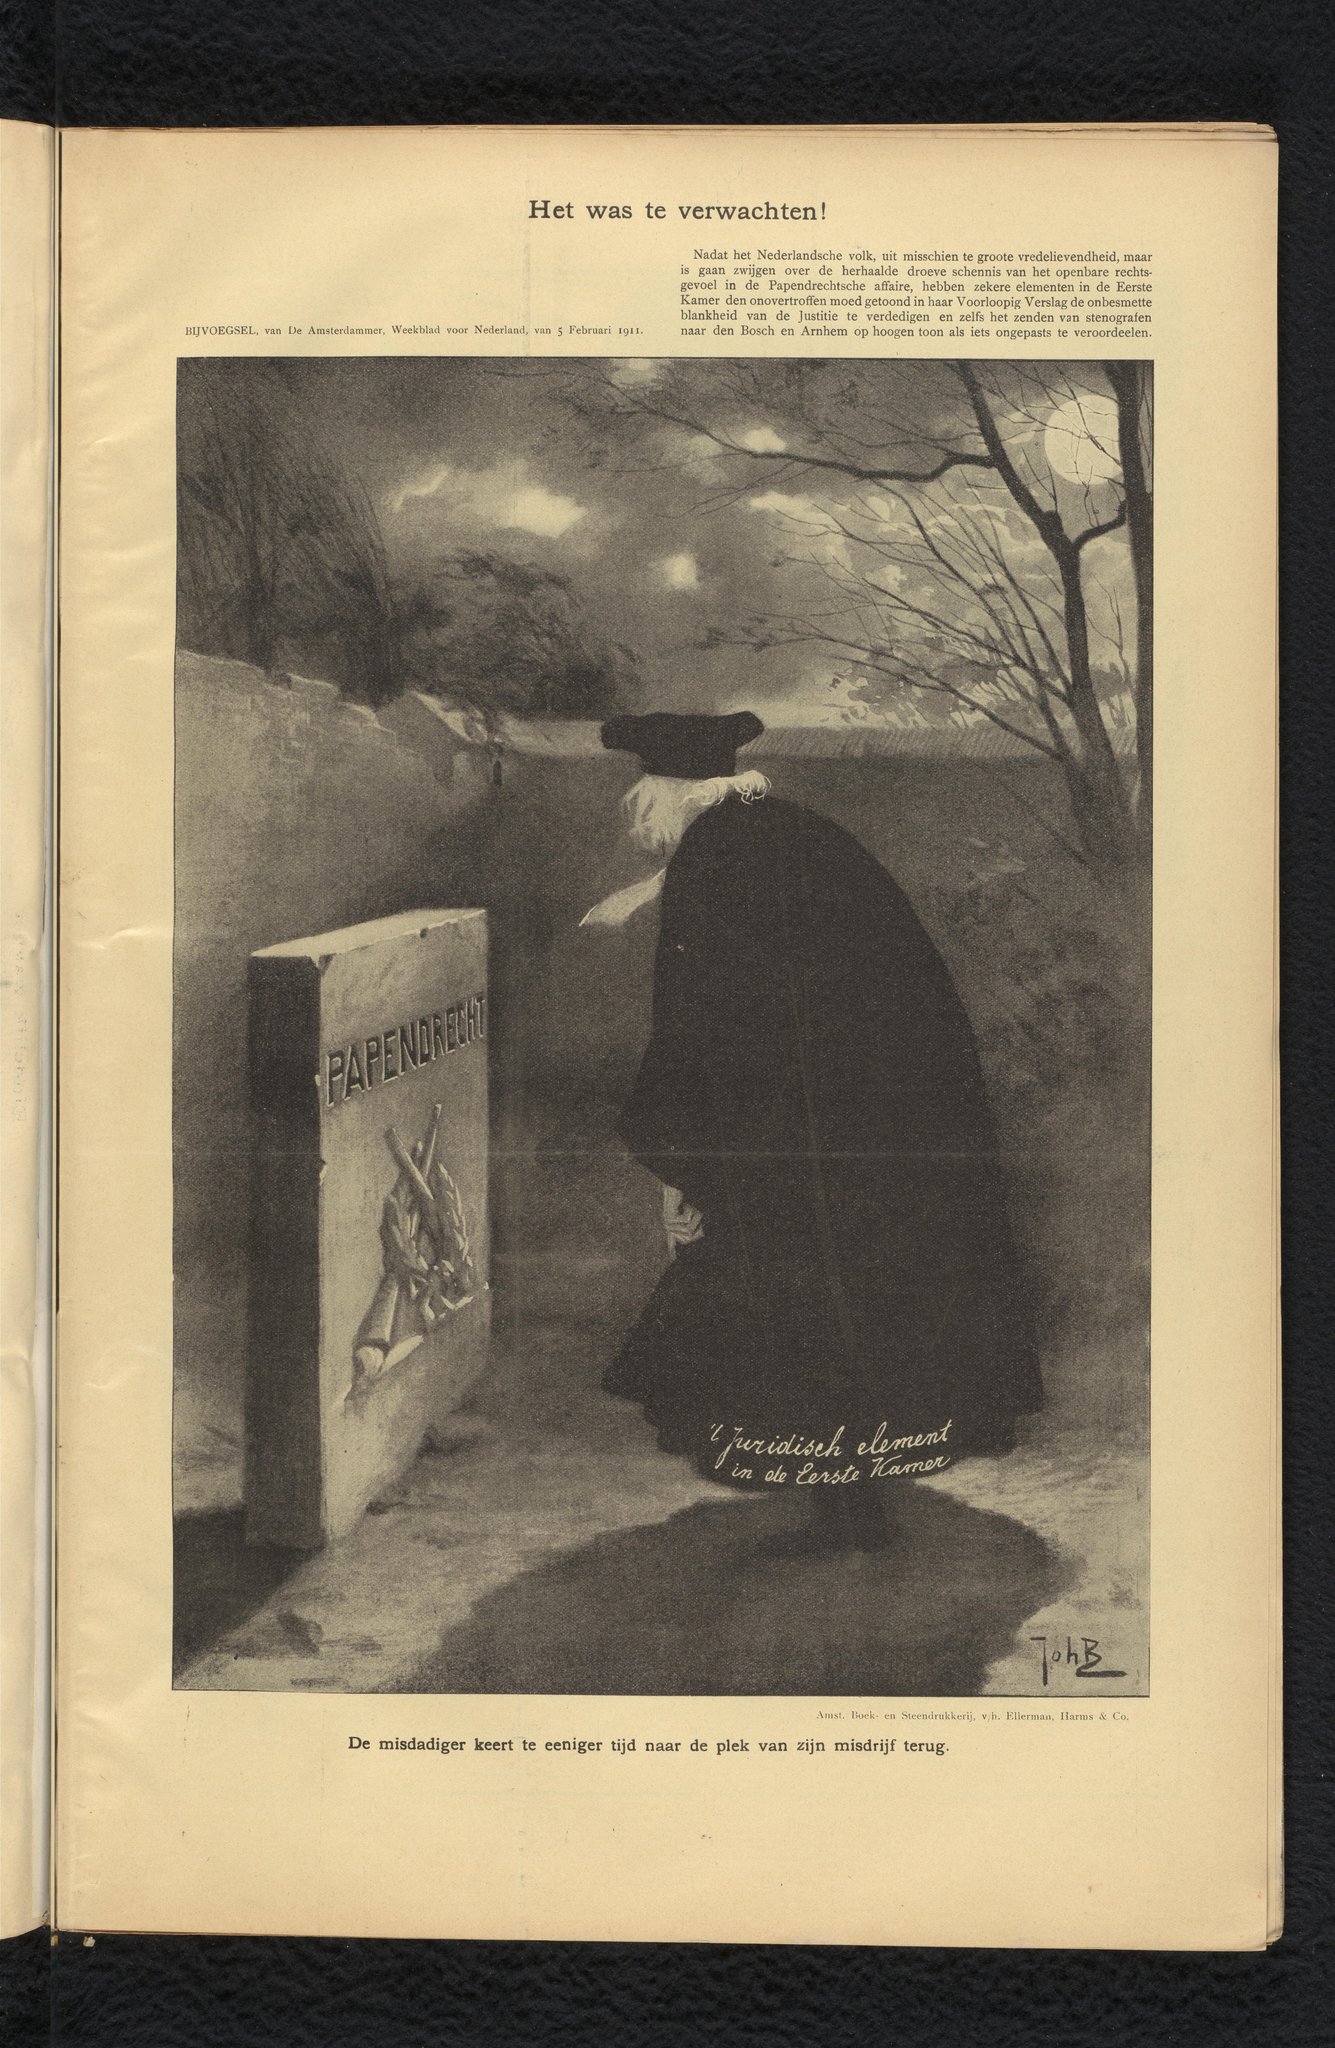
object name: cartoon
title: Het was te verwachten!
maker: johan braakensiek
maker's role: draughtsman, print maker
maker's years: 1858-1940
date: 1911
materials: paper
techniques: autotype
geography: netherlands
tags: magistracy, judges, political caricatures and satires, criminals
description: Een jurist uit de Eerste Kamer als een misdadiger die terugkeert naar de plek van zijn misdrijf, Papendrecht. Naar aanleiding van de zogenaamde 'Papendrechtse affaire'.